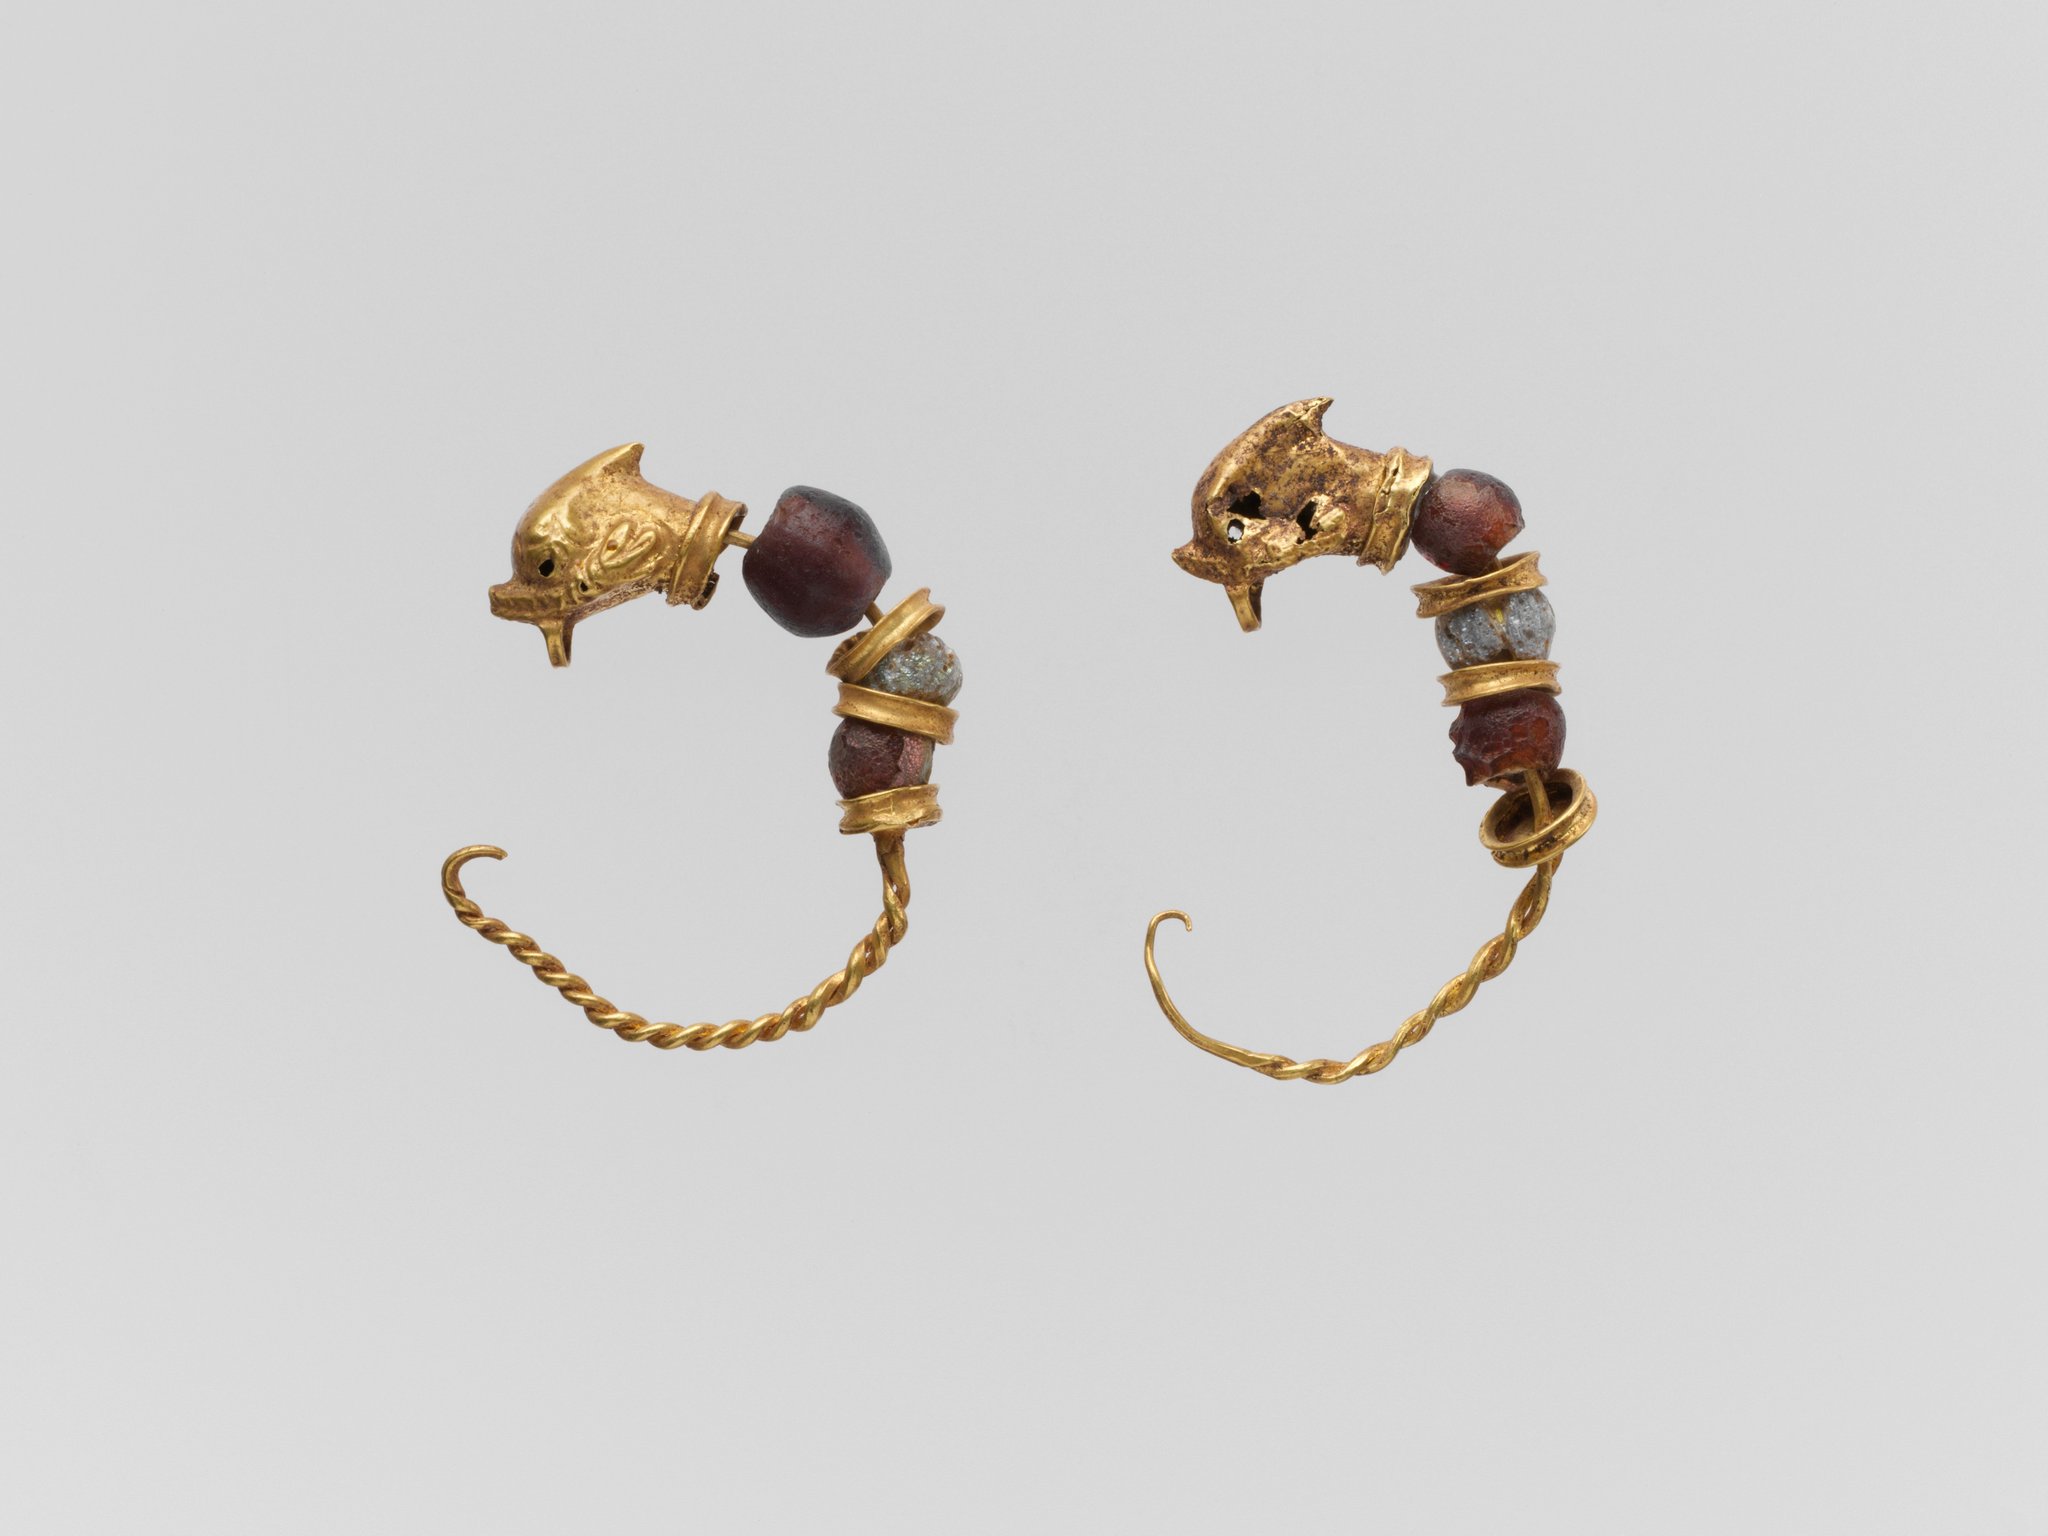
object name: earring with head of dolphin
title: Gold and glass earring with head of a dolphin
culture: greek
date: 200-1 BCE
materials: glass, gold, paste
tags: dolphins